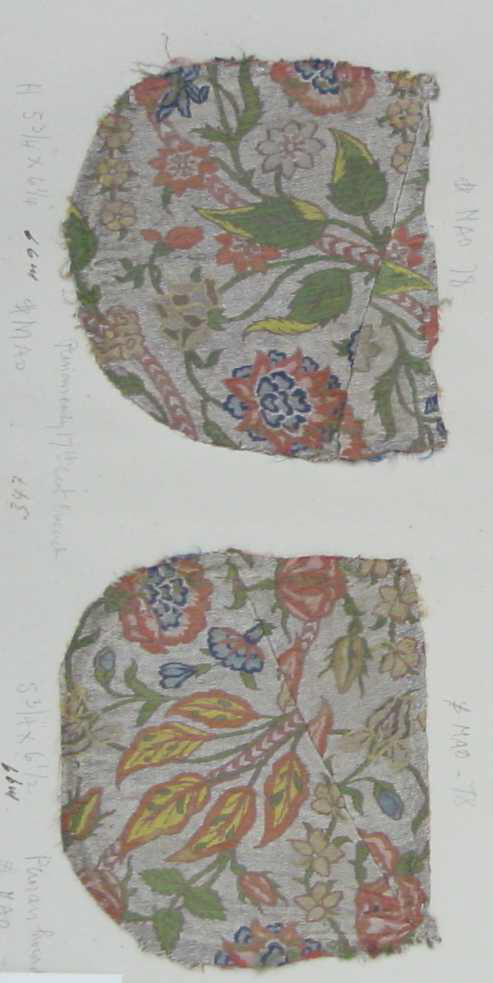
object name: textile fragment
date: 1601-1700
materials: metal thread, silk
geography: iran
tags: flowers,leaves